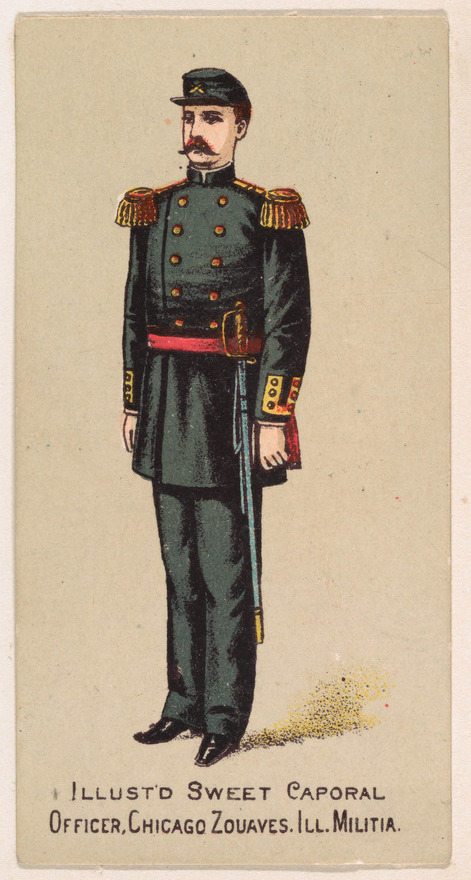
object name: print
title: Officer, Chicago Zouaves, Illinois Militia, from the Military Series (N224) issued by Kinney Tobacco Company to promote Sweet Caporal Cigarettes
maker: kinney brothers tobacco company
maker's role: publisher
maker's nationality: american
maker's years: 1869-2011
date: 1888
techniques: color lithograph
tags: military,swords,men